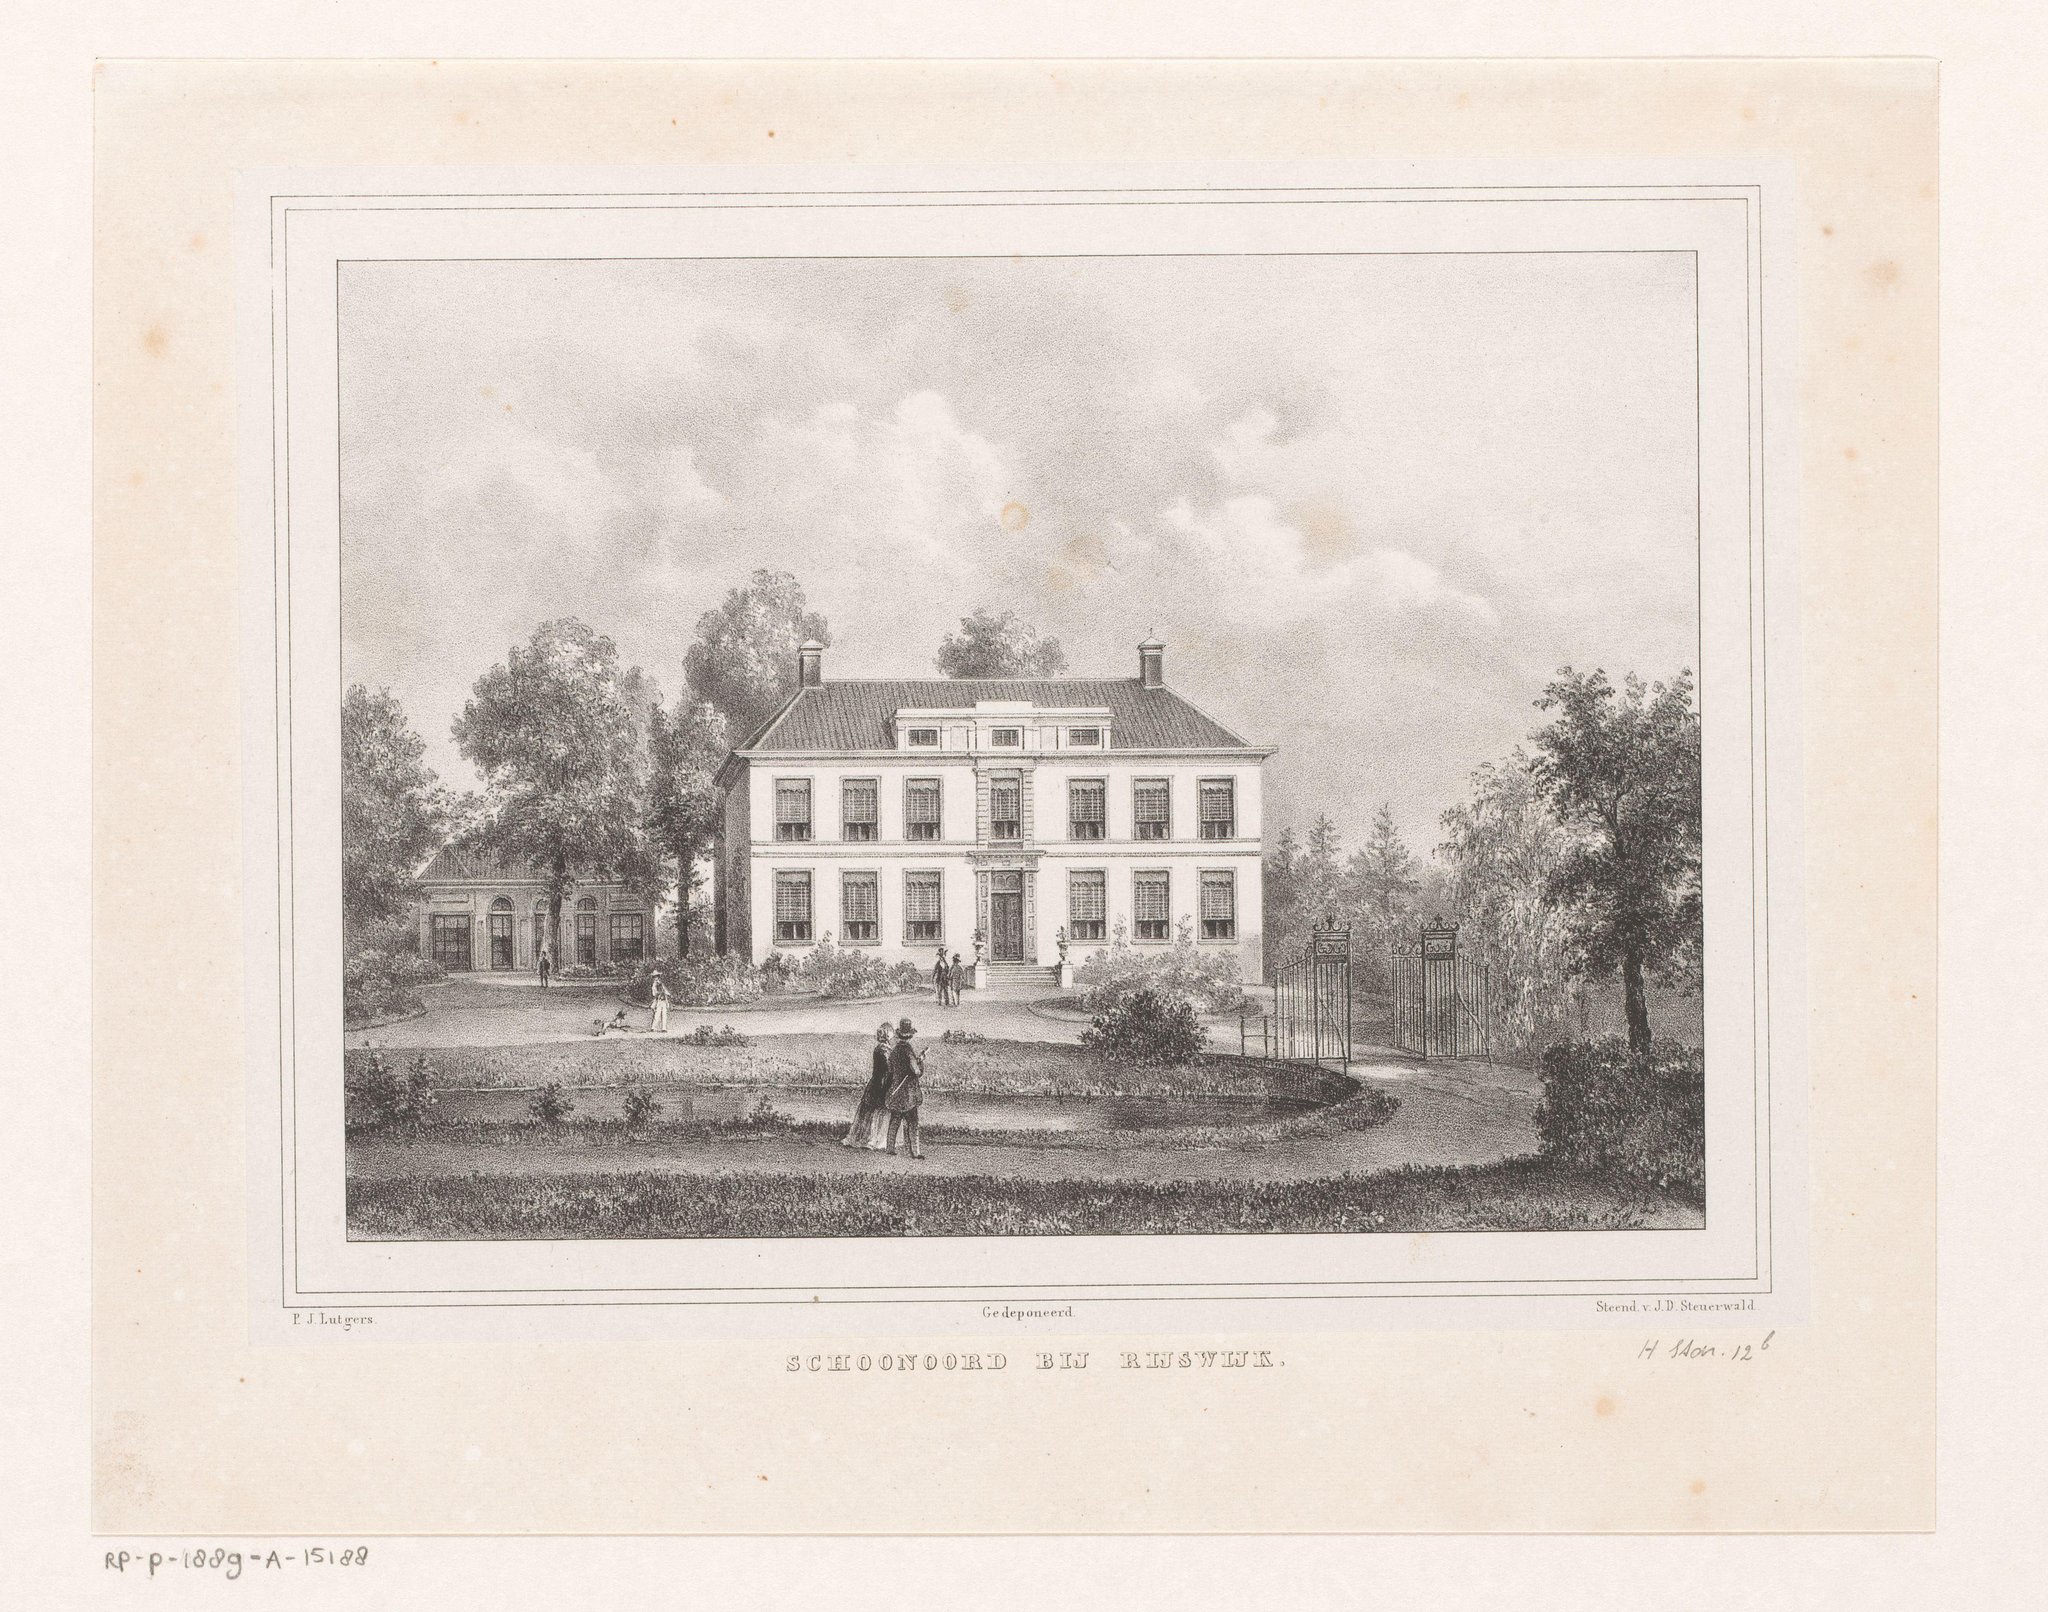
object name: print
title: Gezicht op buitenplaats Schoonoord in Rijswijk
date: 1855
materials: paper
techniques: lithograph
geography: loenen aan de vecht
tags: country-house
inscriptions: collector's mark: Lugt 2228, collector's mark: ‘Gedeponeerd.’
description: Op het pad en de oprijlaan lopen figuren.